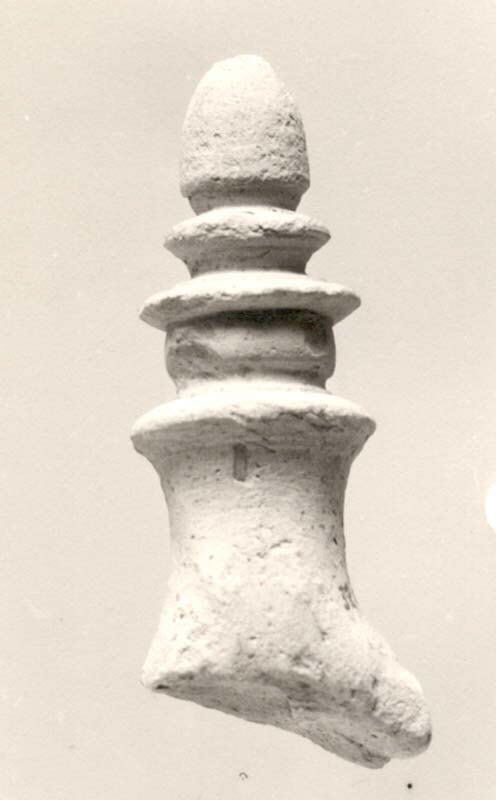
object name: handle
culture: sasanian or islamic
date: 501-800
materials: ceramic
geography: mesopotamia